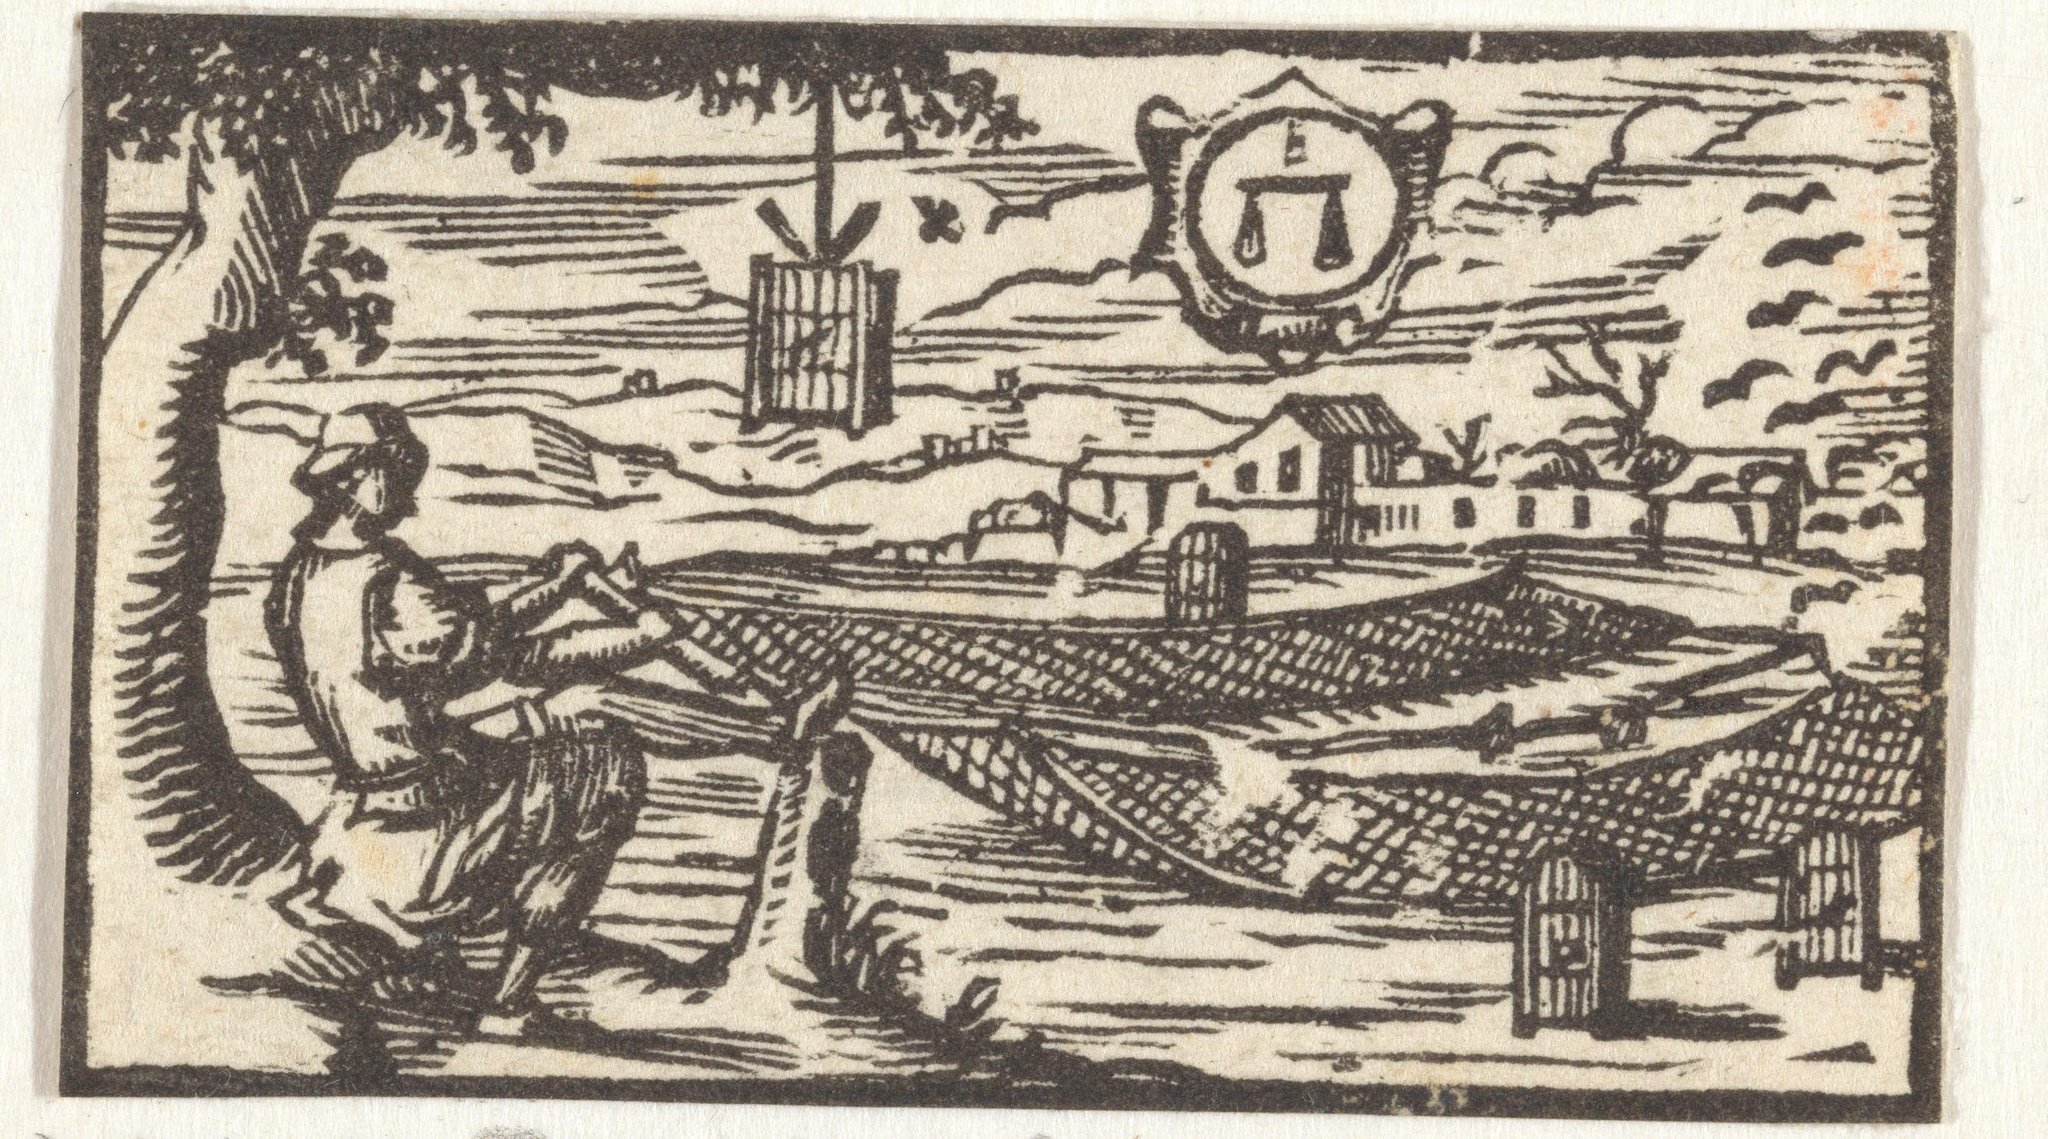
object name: print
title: September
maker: Anonymous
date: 1600-1699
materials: paper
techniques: woodcut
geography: netherlands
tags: september and its 'labours' (+ with libra (september)), fisherman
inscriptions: collector's mark: Lugt 2228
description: Een visser aan het water zijn netten ophalend. Midden boven een weegschaal.